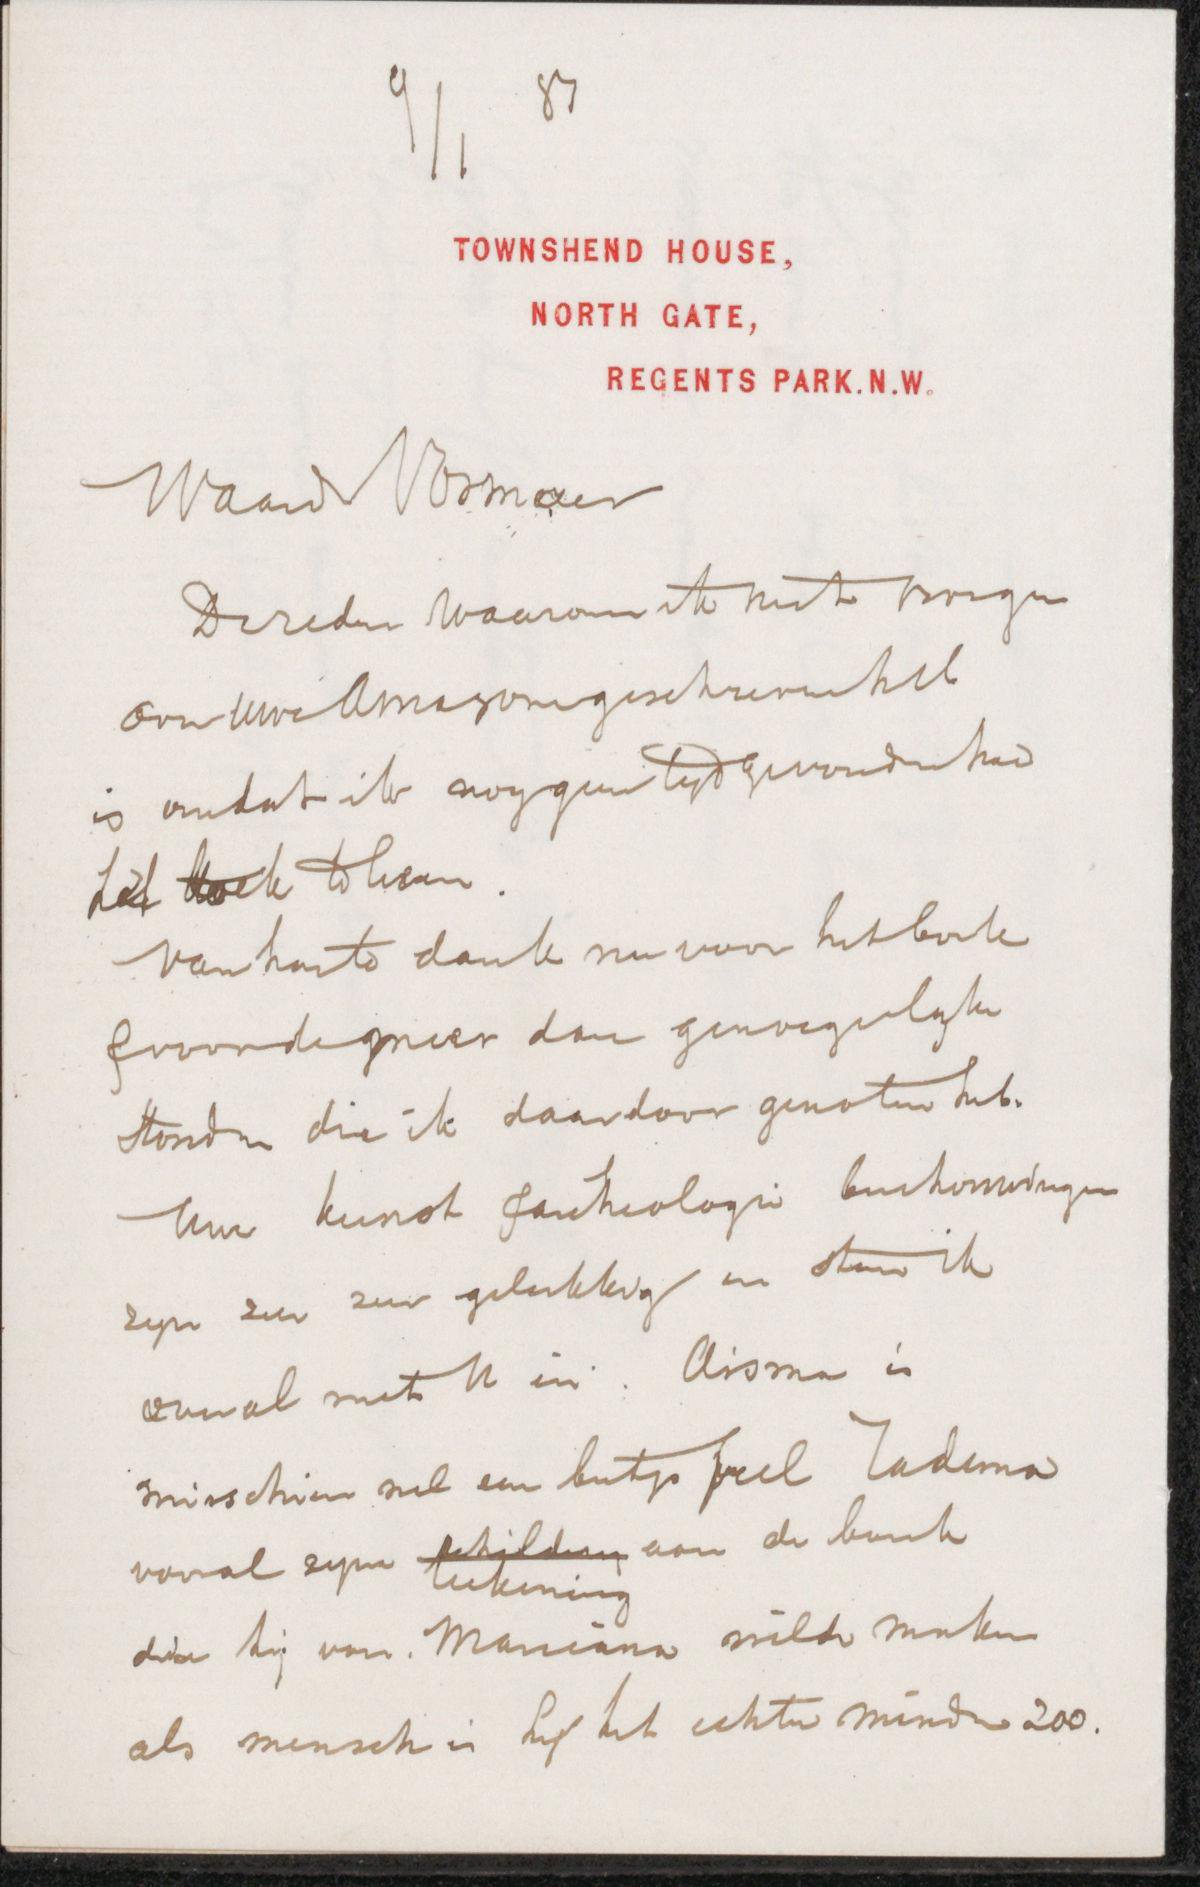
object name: letter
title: Brief aan Carel Vosmaer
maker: lourens alma tadema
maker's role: draughtsman, print maker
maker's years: 1836-1912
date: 1881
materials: ink, paper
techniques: pen, printing, writing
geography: london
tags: carel vosmaer, edmund william gosse, literature ~ arts, italy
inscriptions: watermark